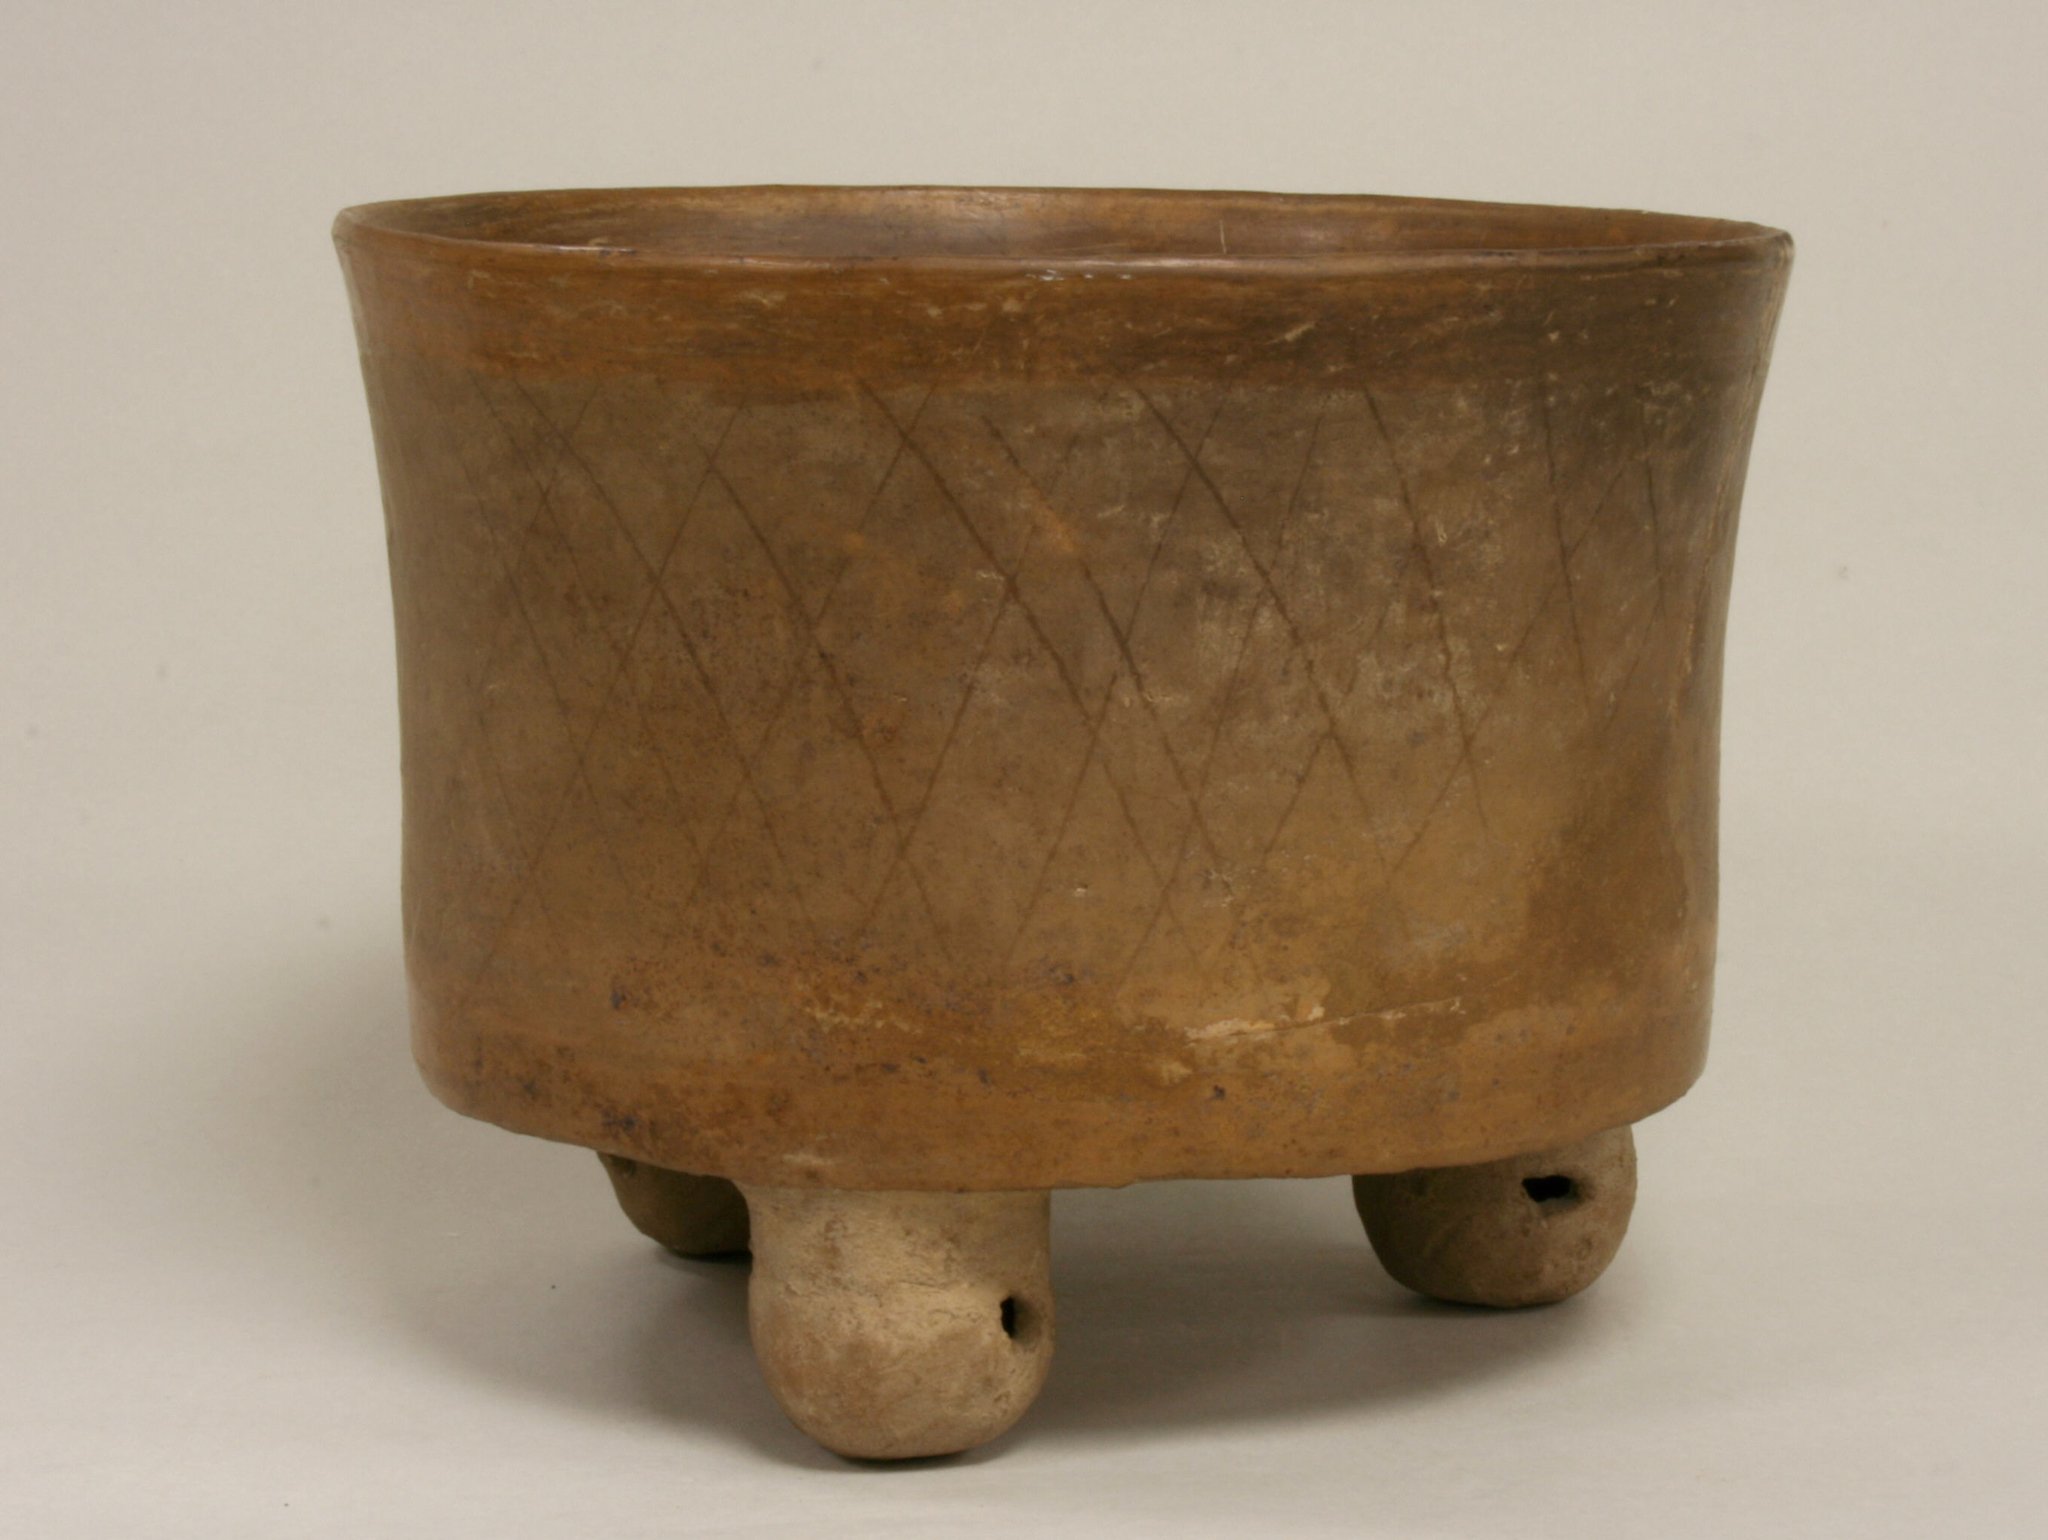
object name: vessel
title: Tripod Vessel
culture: teotihuacan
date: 401-500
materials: ceramic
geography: mexico